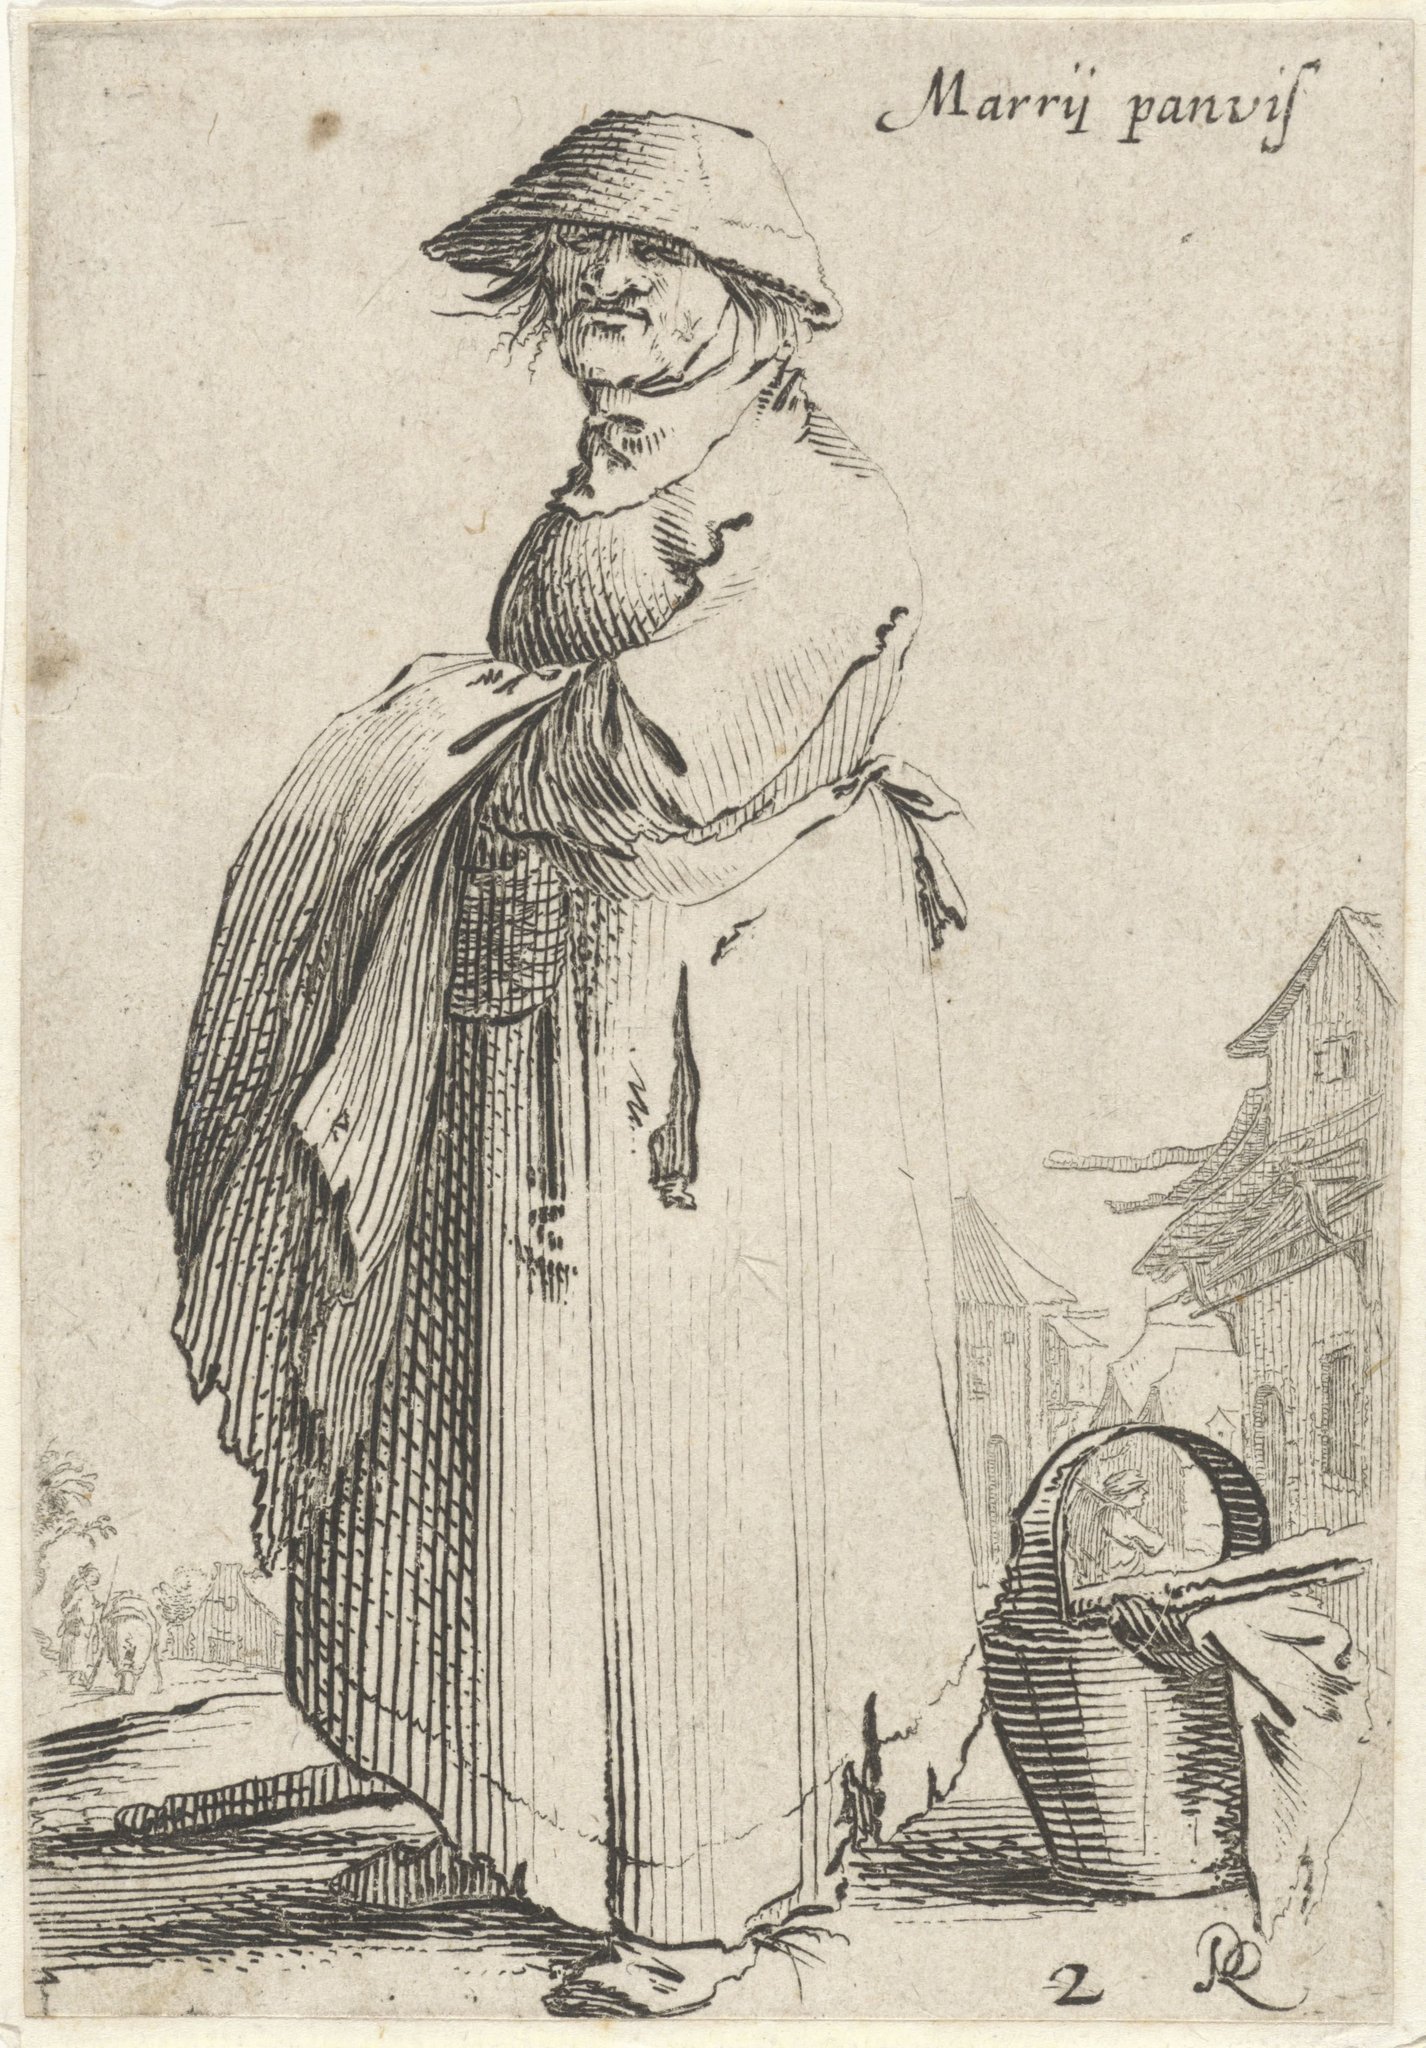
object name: print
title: T'Leven Der Boeren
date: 1630-1665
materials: paper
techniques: engraving, etching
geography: amsterdam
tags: wooden container: barrel, cask, bucket, farmers, textile fabric, cloth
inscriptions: collector's mark: Lugt 2228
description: De prent maakt deel uit van een twaalfdelige serie prenten met voorstellingen van boeren.